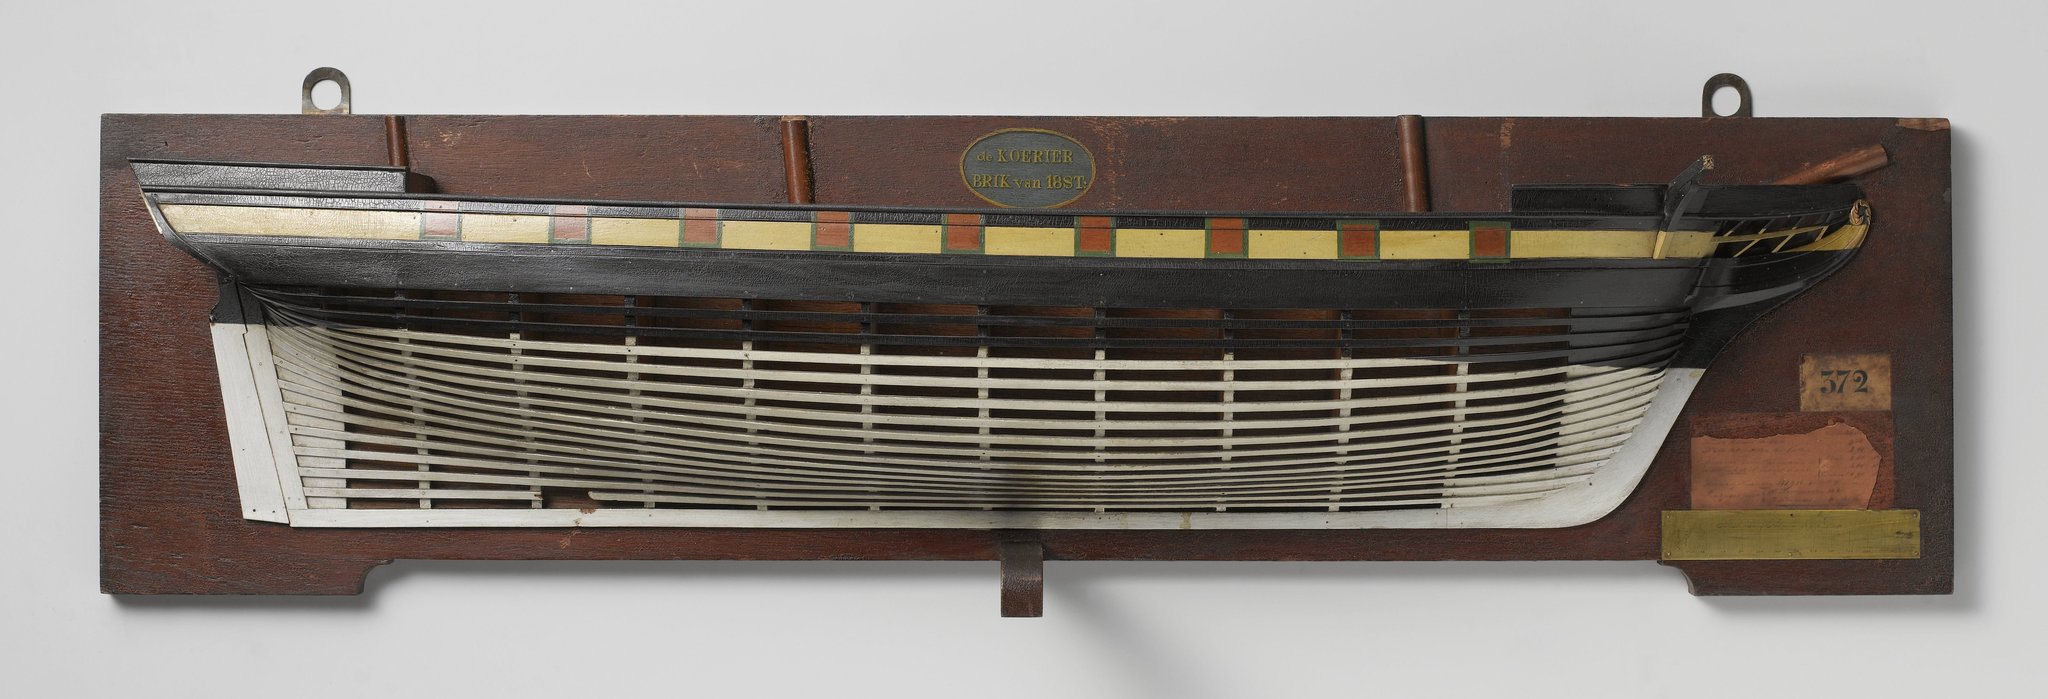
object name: half model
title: Half Model of an 18-Gun Brig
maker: Anonymous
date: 1826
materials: wood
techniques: polychromy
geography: flushing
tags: koerier (schip)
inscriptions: scale, bottom right: brass scale in inches, inscription, top centre, on a blue roundel, painted: ‘de KOERIER / BRIK van 18 ST.’, label, centre right: ‘372’ former inventory label, inscription, bottom right, on a piece of paper, in ink: measurements and armament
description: Gepolychromeerd mallenmodel (stuurboord) van een driemaster. De huid boven het barkhout is gesloten, negen geschilderde geschutpoorten op één dek. Voorschip uitgewerkt met galjoen en schegbeeld van een vergulde krul, een leeuwenmasker op de kraanbalk. Gewrongen spiegel, hol wulf, hek met half rijkswapen, geen zijgalerij; roer met ronde roerkoning (Soetermeers versie). Zeeg naar voor en achter iets oplopend, één barkhout en één reehout. Gepiekt rondspant. Schaal 1:40 (schaal op model).